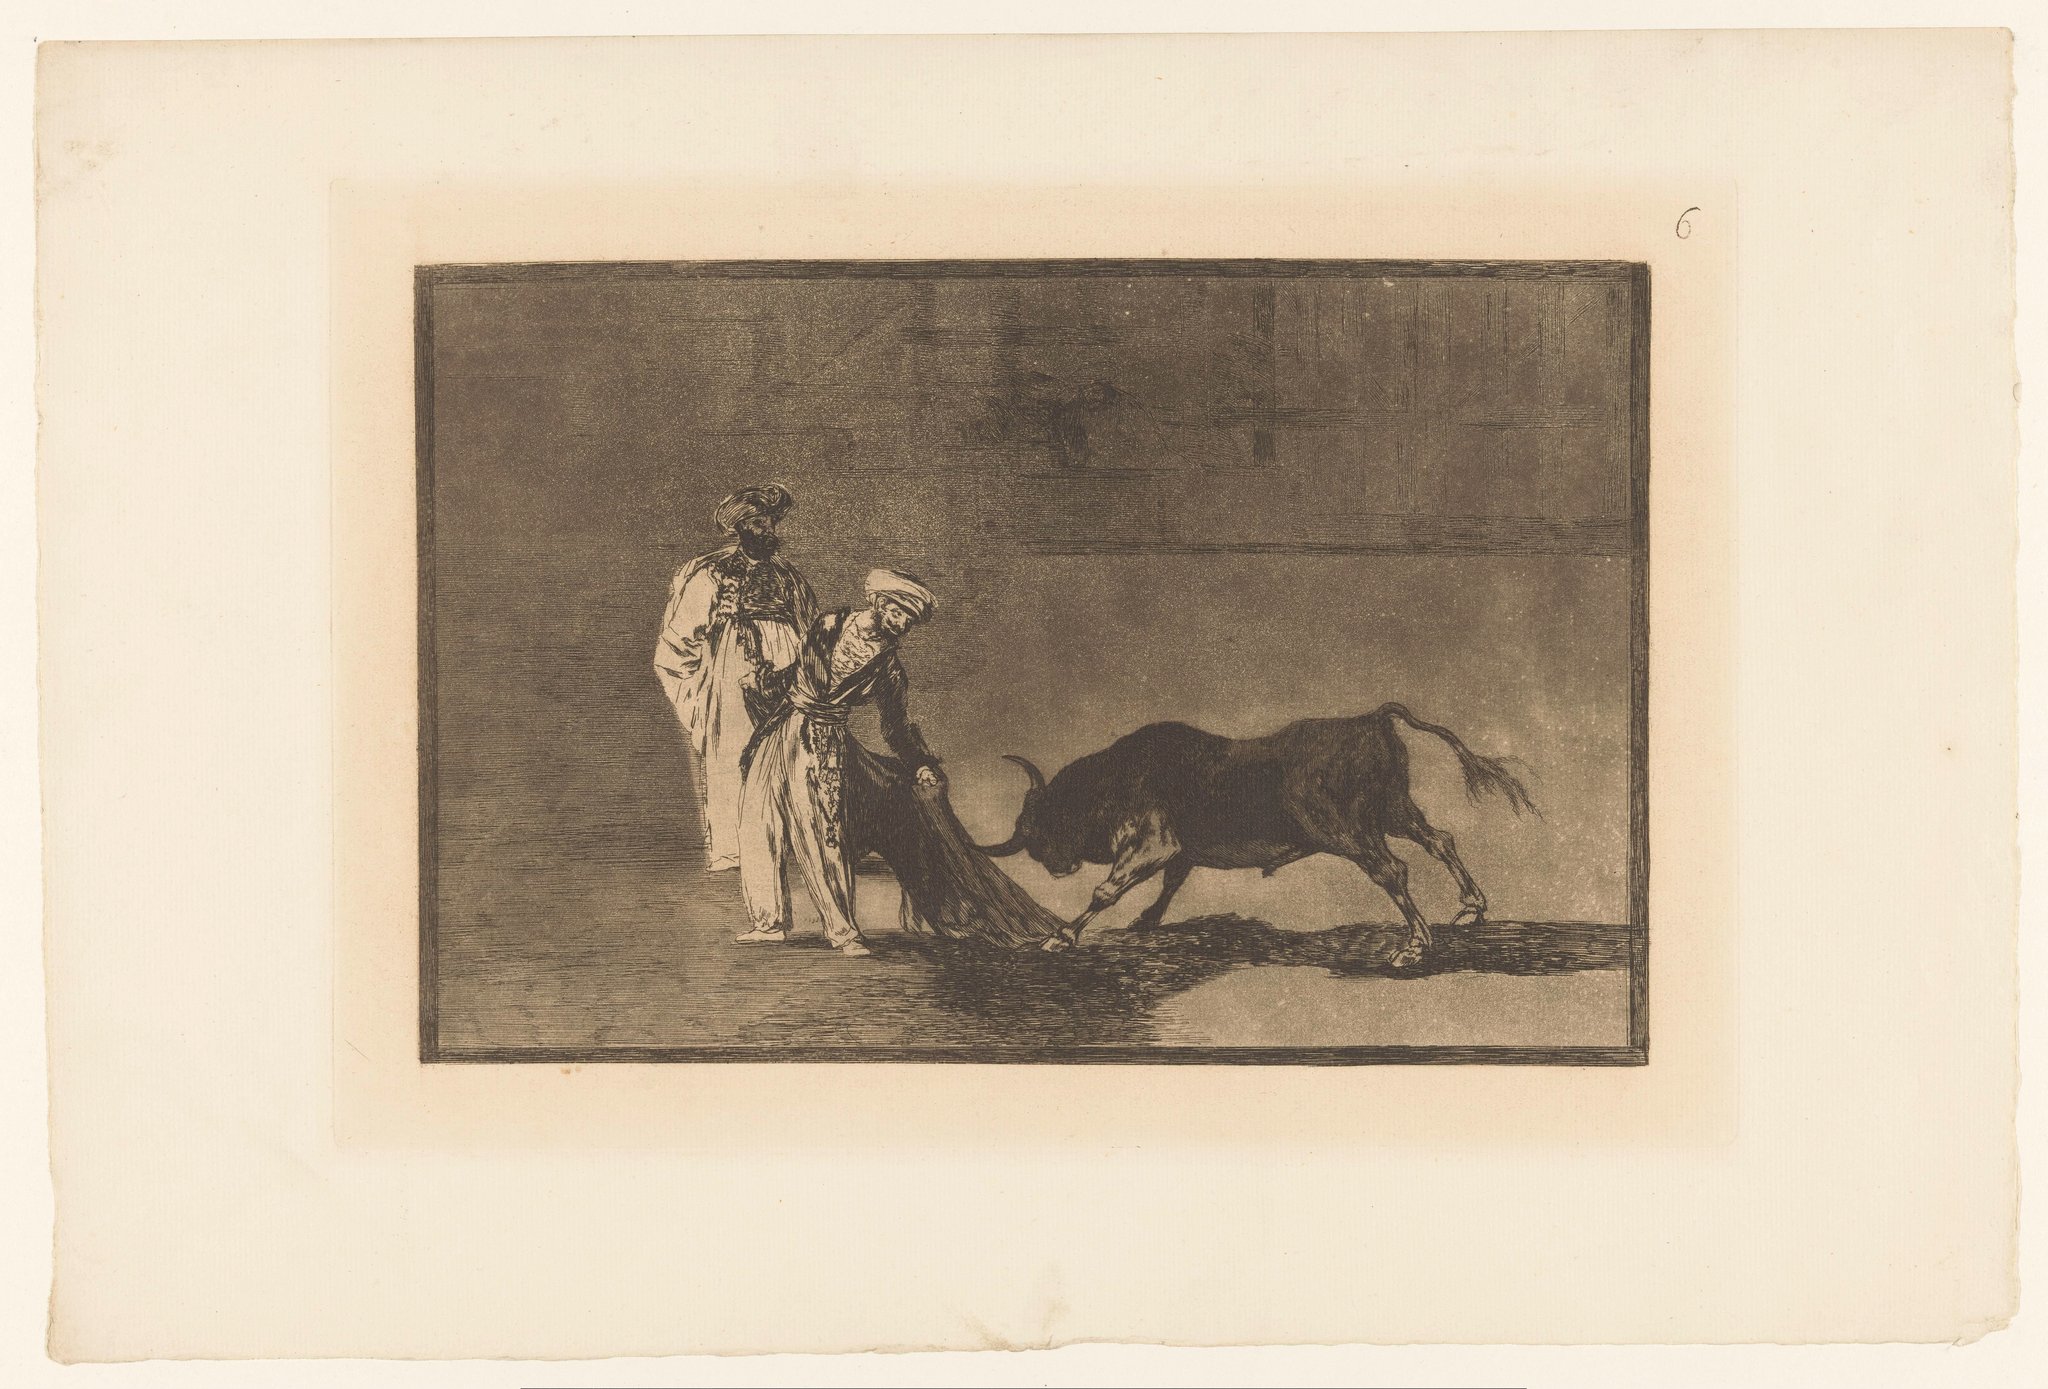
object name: print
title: La Tauromaquia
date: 1876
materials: paper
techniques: aquatint, etching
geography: paris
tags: bull, bullfight, head-gear: turban, bull-fighter, toreador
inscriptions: collector's mark: Lugt 2228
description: Deze prent maakt deel uit van een serie van 40 prenten door Francisco de Goya met voorstellingen van stierengevechten. De eerste editie bestond uit 33 genummerde prenten en werd uitgegeven in 1816. Dit betreft de derde editie, uitgegeven in 1876 door Eugène Loizelet en door hem voorzien van een titelprent en lijst met titels. Naast de 33 prenten publiceerde Loizelet ook de prenten die door Goya op de achterkanten van 7 van de platen werden geëtst. Deze zijn niet voorzien van nummers maar van de letters A-G.